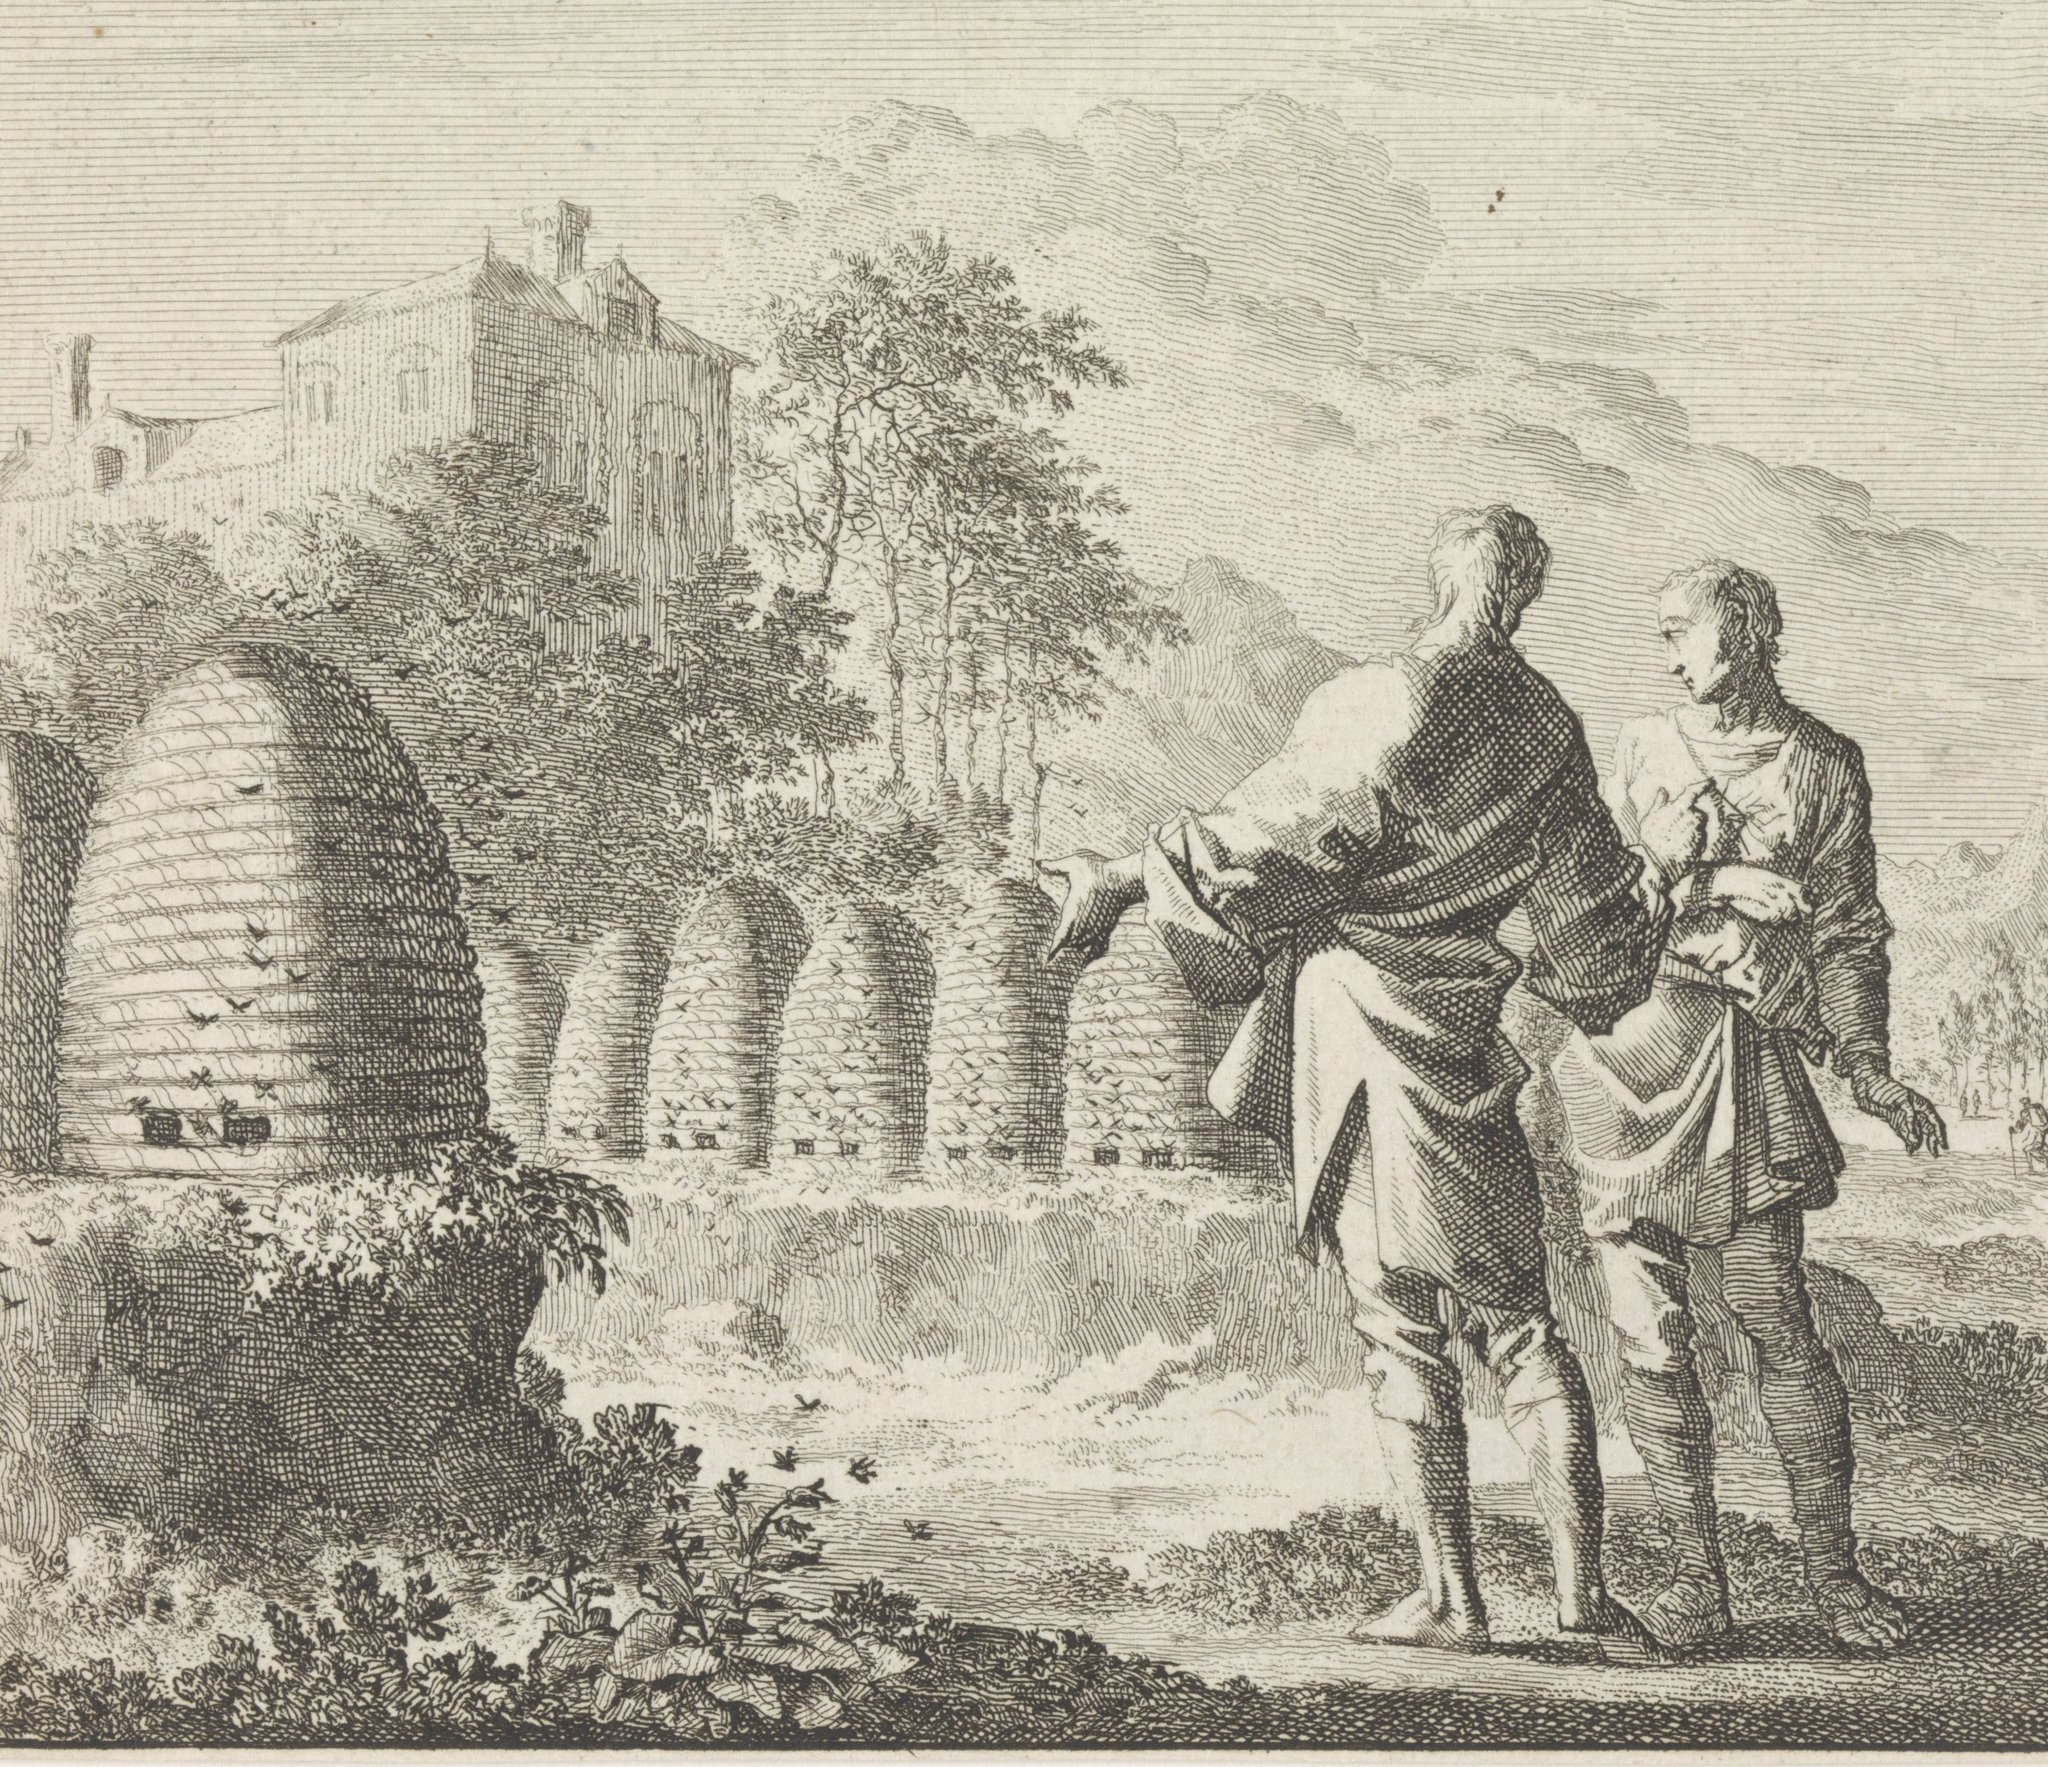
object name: print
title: Embleem: bijen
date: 1695-1705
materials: paper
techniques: etching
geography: amsterdam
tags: adult man (+ two persons), bee-hive, insects: bee, abstract ideas and concepts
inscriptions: collector's mark: Lugt 240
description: Boekillustratie voor Weigel, Christoph. Ethica Naturalis seu Documenta Moralia e Variis rerum Naturalium proprietatibus Virtutum Vitiorumq symbolicis imaginibus collecta. Neurenberg: Christoph Weigel: c. 1700.